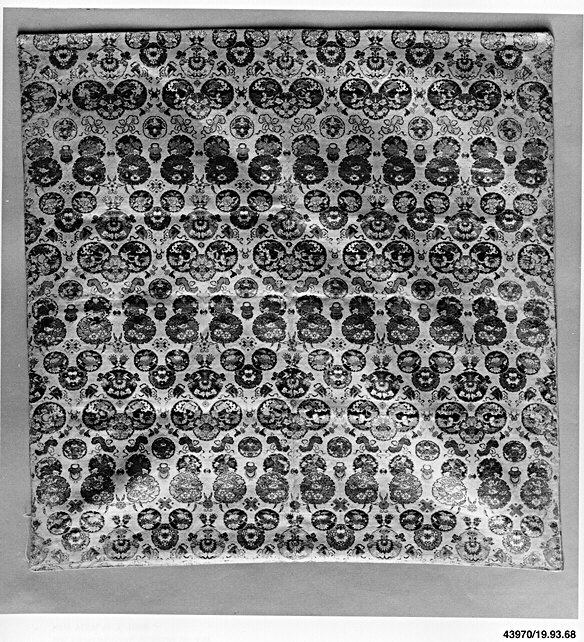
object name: altar cloth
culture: japanese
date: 1688-1704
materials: metal thread, silk